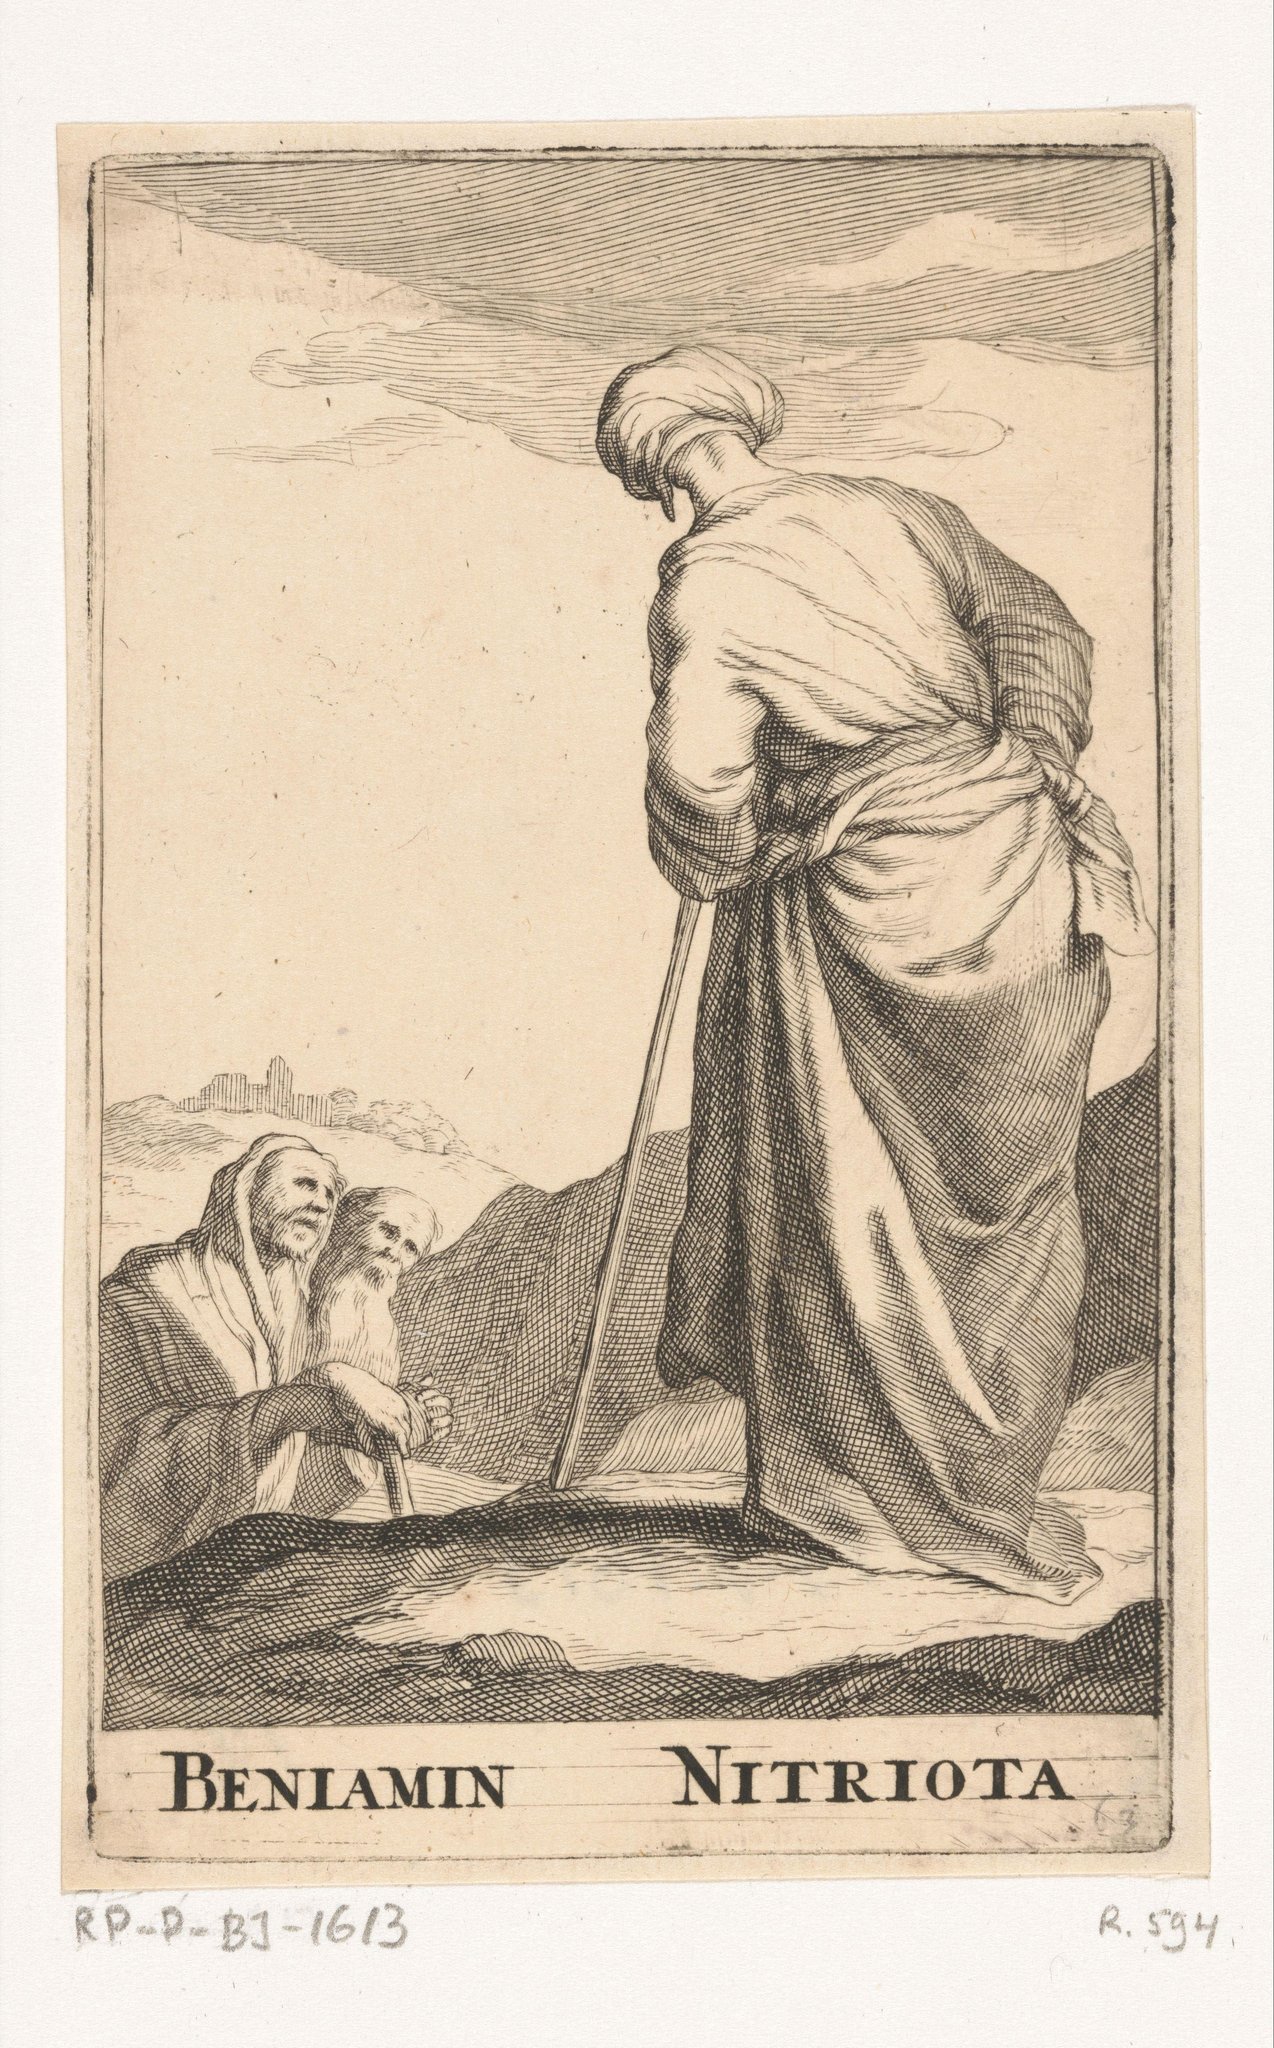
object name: print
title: Kluizenaars: Thebaanse heiligen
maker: frederick bloemaert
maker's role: print maker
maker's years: 1614-1669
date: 1636-1670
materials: paper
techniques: engraving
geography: utrecht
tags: male saints (benjamin of nitria)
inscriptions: number: ‘63’, collector's mark: Lugt 240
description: De heilige Benjamin van Nitria, op de rug gezien, als oude, misvormde man, geneest twee oudere mannen. Prent uit een serie van 80 prenten en een titelprent met kluizenaars uit de 2e tot de 6e eeuw.